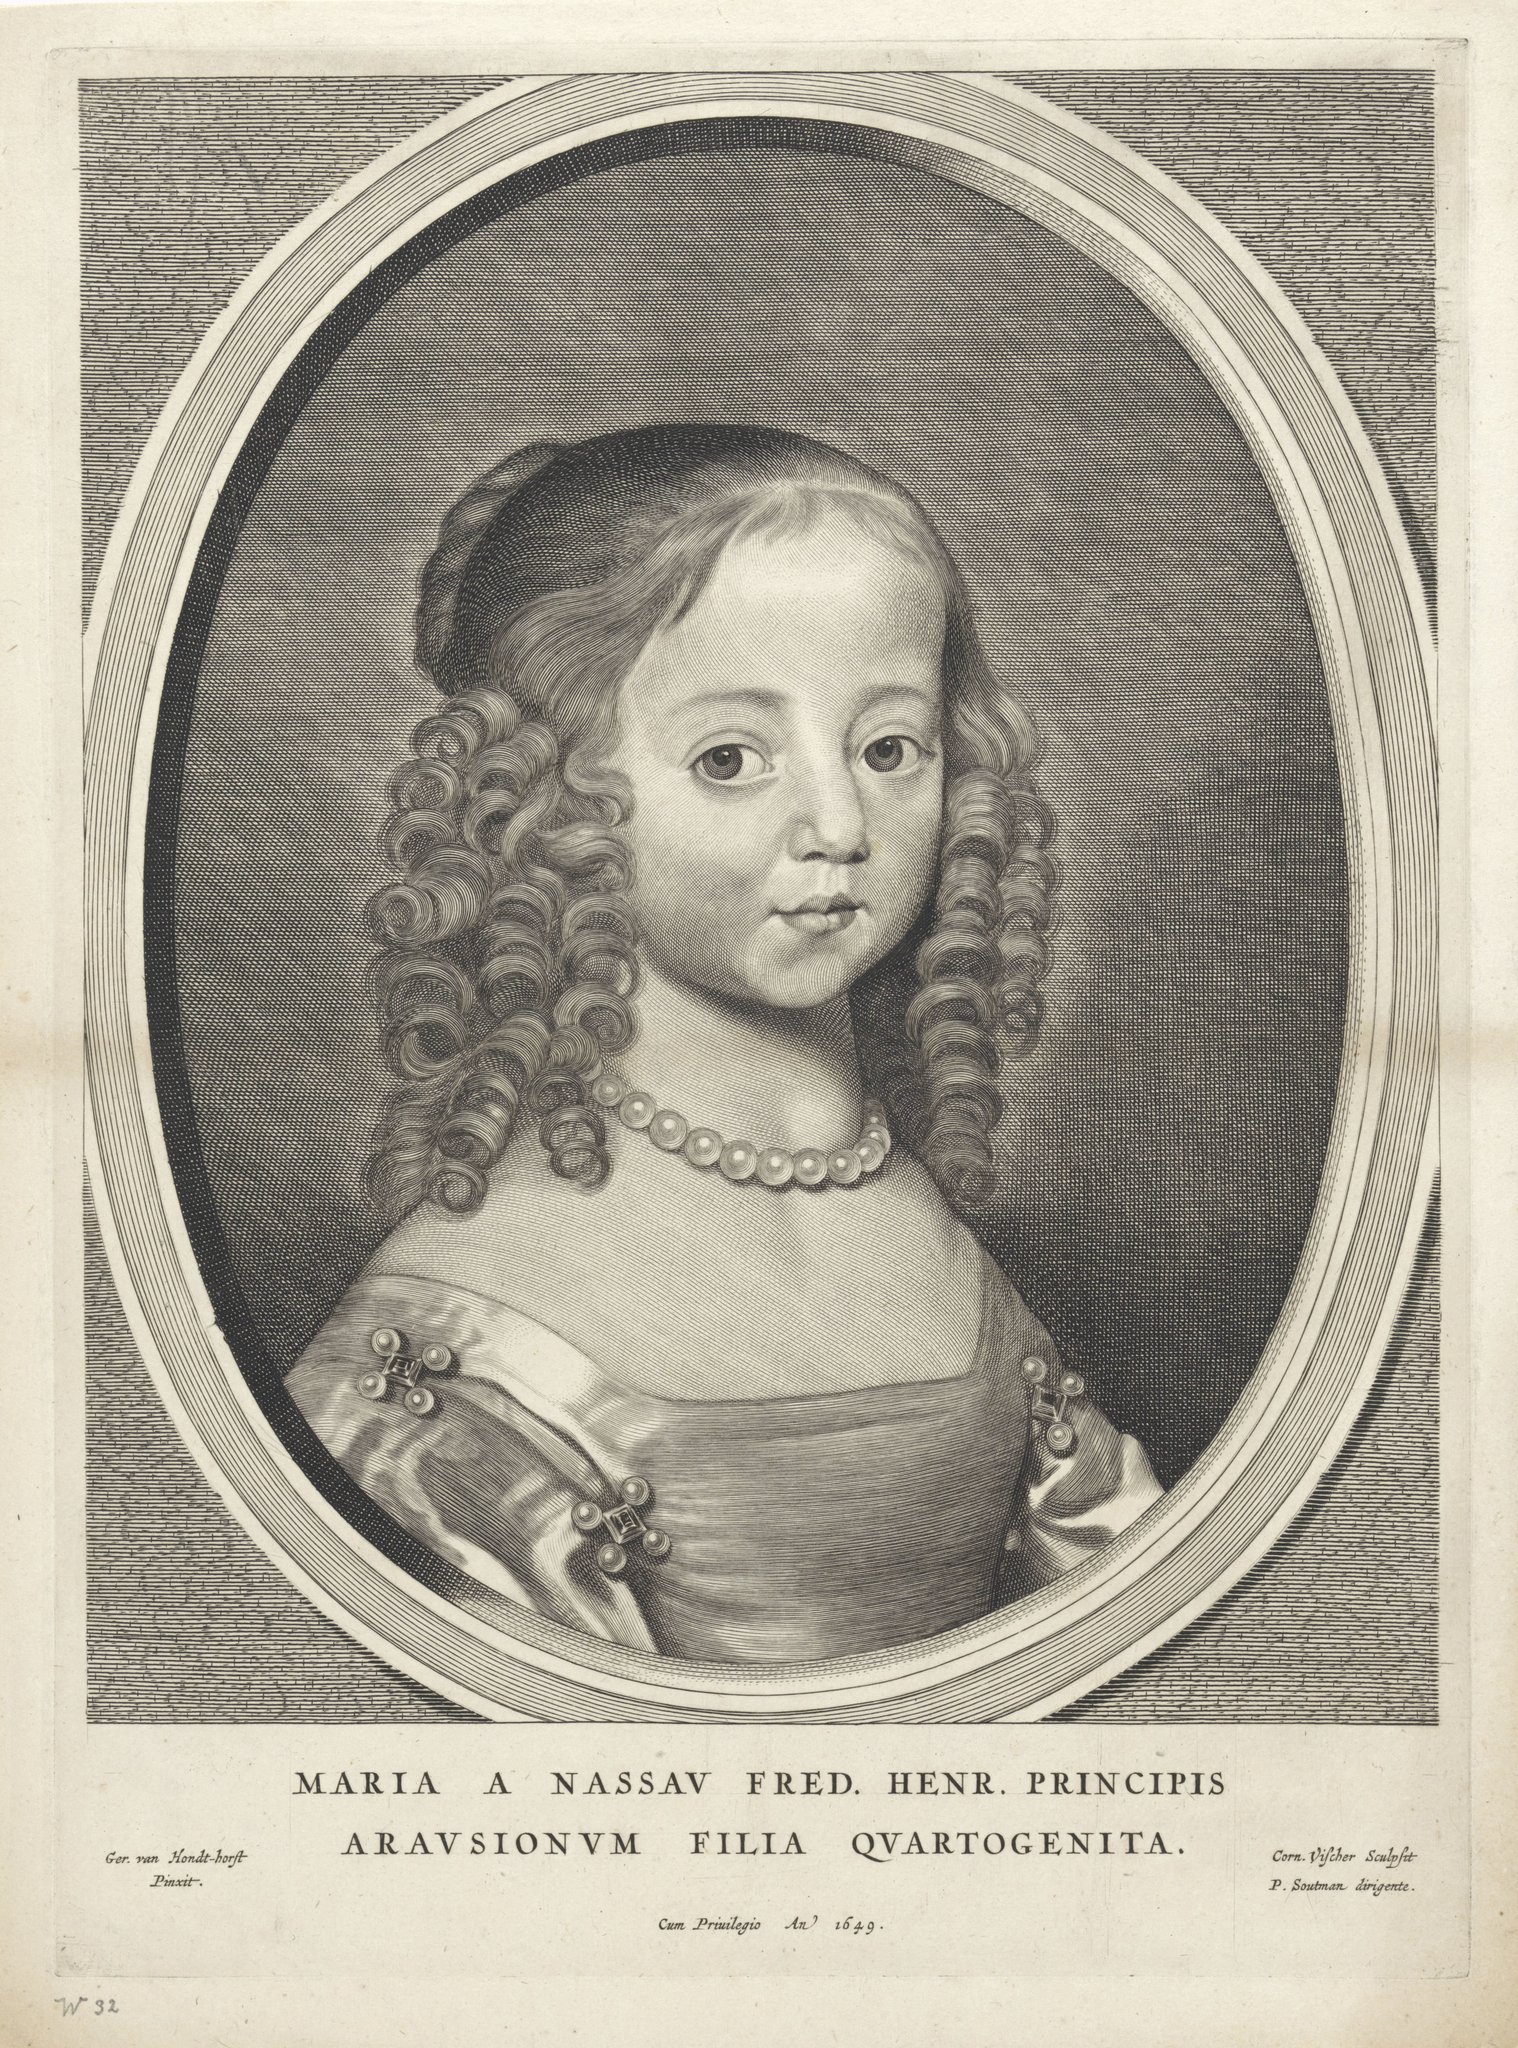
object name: print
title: Oranjeportretten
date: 1649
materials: paper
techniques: engraving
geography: haarlem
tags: maria (prinses van oranje) (1642-1688), fashion, clothing, pearl; pearl necklace (+ women's clothes)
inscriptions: collector's mark: Lugt 2233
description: Maria, prinses van Oranje op jonge leeftijd. Om haar hals een parelsnoer. Prent uit een serie van 9 prenten met Oranjeportretten.